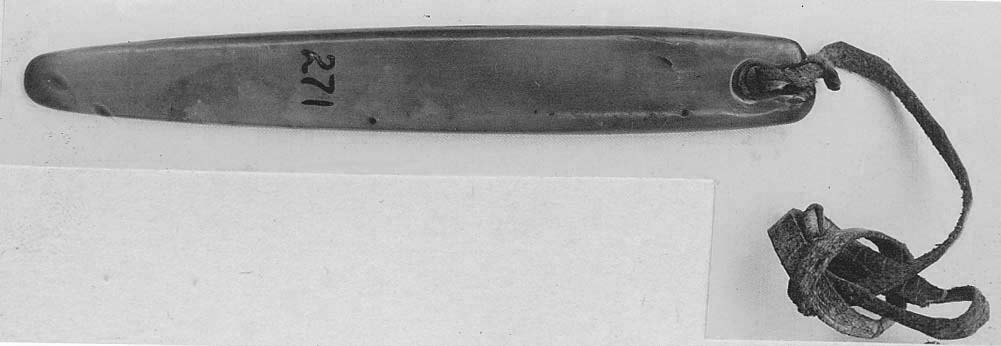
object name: knife sharpener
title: Knife-sharpener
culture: north american, alaskan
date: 1902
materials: jade